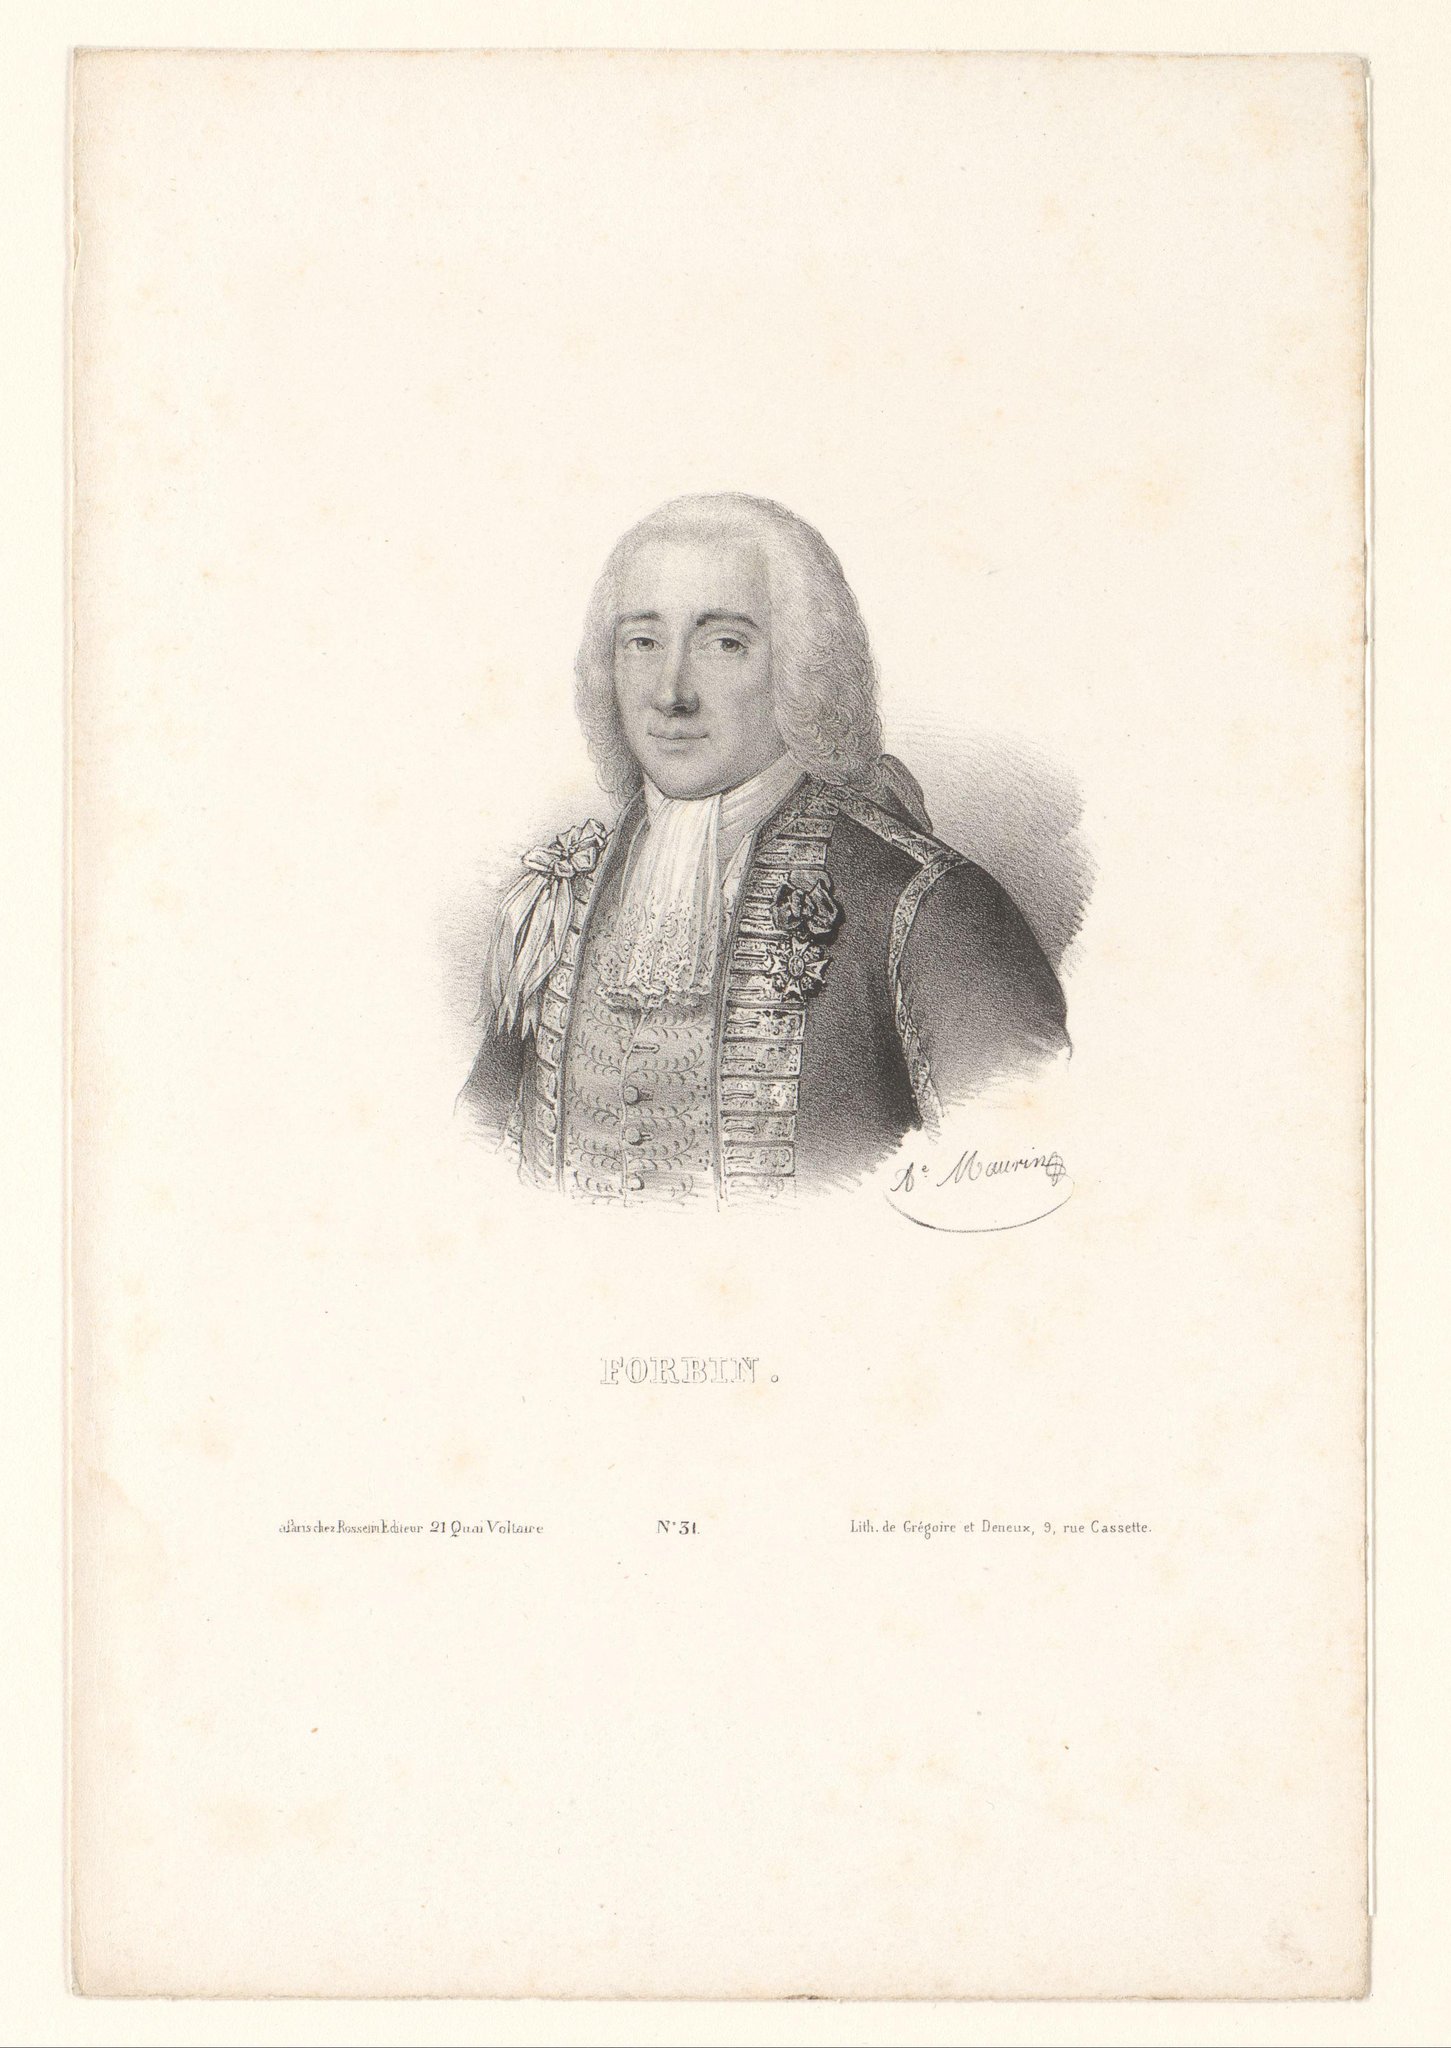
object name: print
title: Portret van marine-officier Claude de Forbin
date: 1835-1851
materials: paper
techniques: lithograph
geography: paris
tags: marseille, historical persons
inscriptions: collector's mark: Lugt 2228